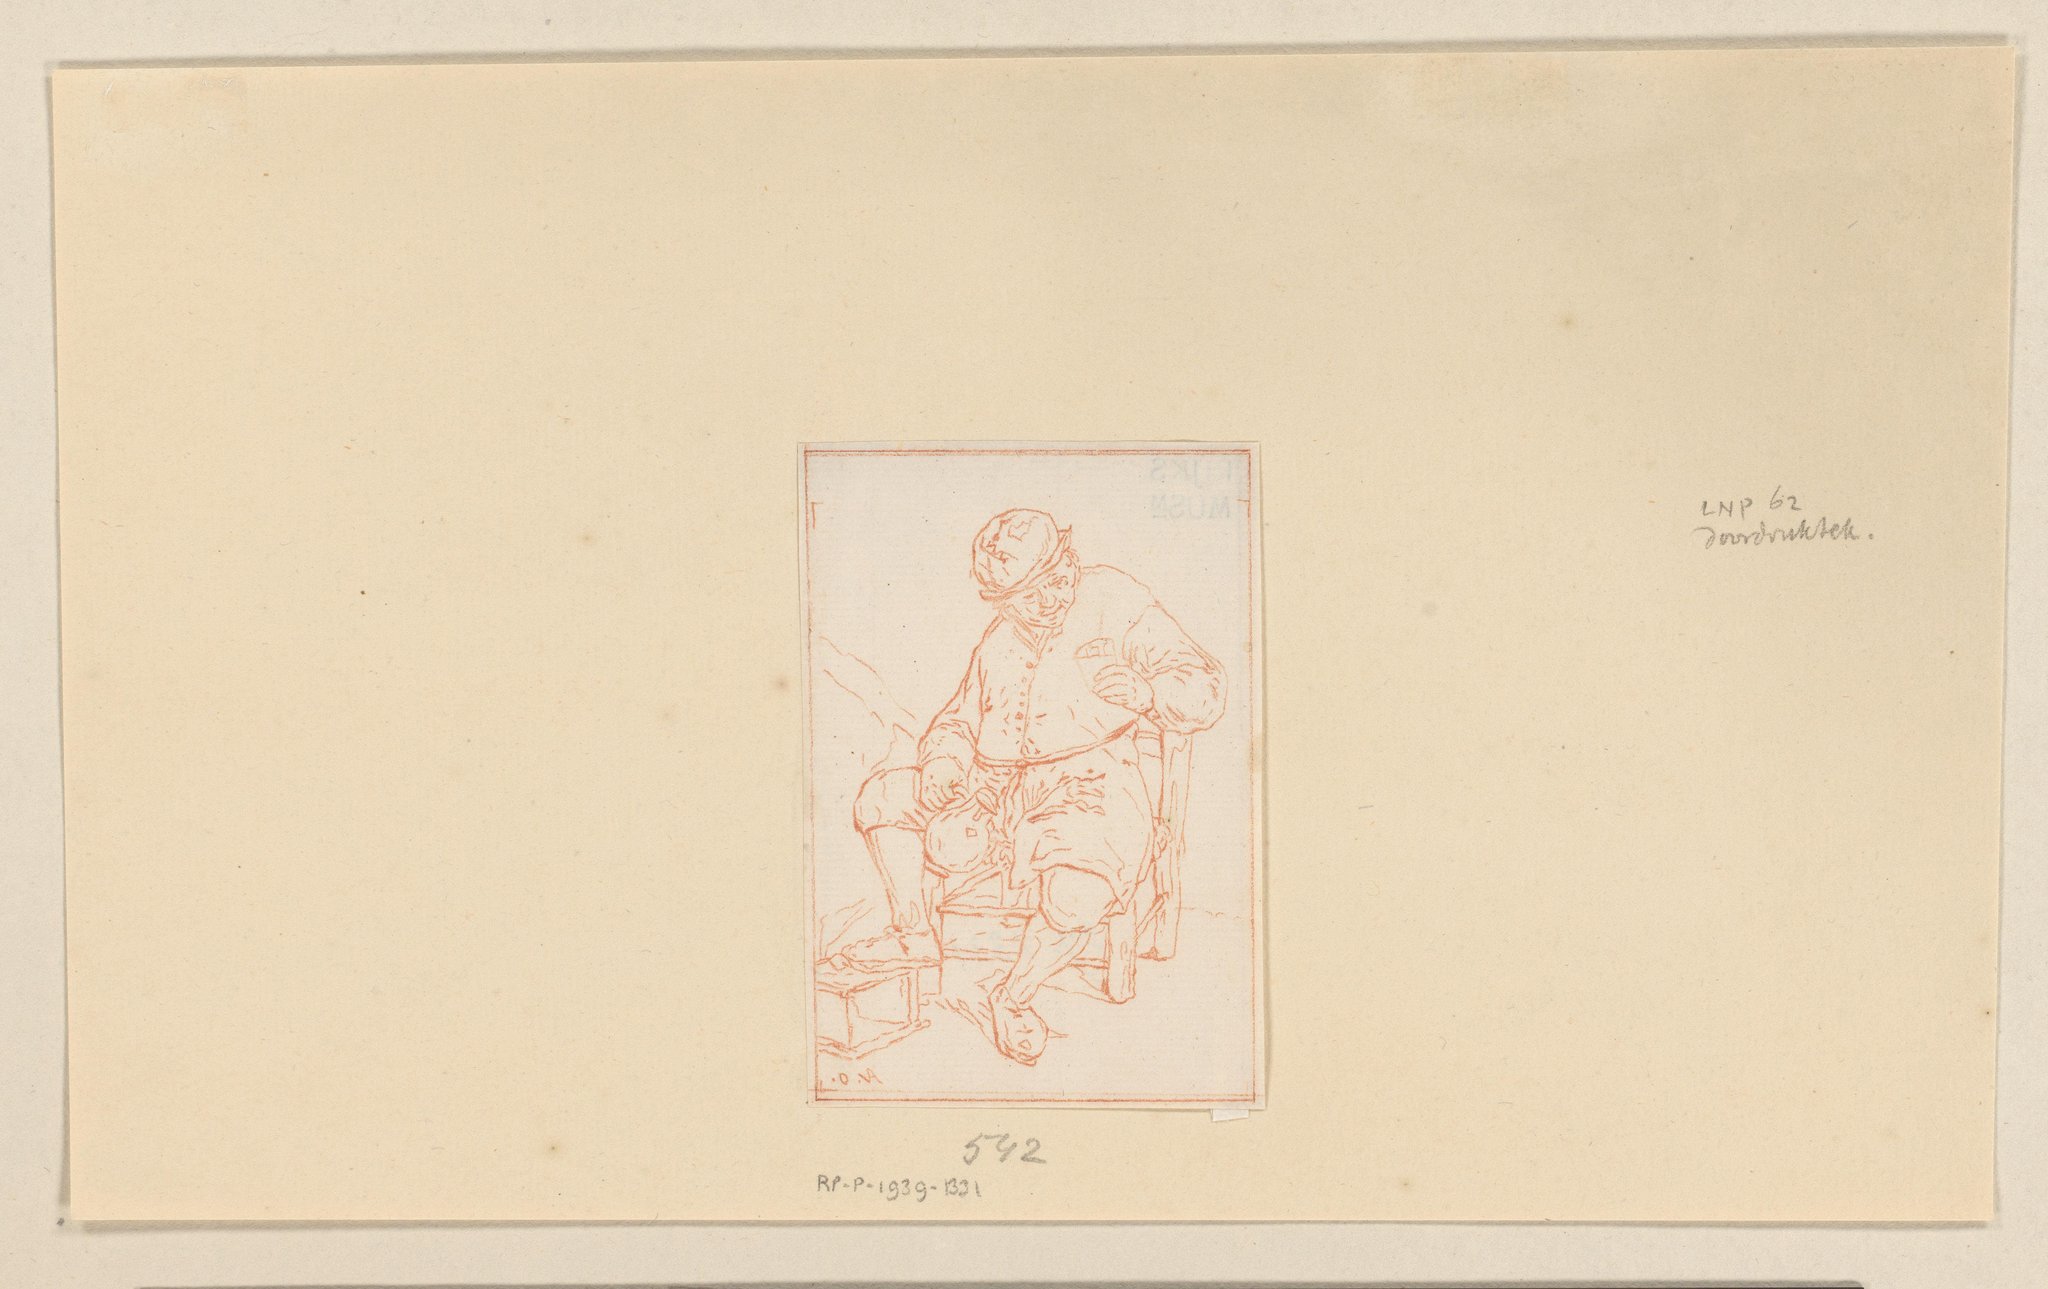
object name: drawing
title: Zittende boer met kruik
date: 1739-1798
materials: chalk, paper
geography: amsterdam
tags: sitting figure, jar, jug (used as drinking-vessel)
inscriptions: collector's mark: ‘RIJKS / MUSM’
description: Een boer zit op een stoel met een glas in de ene en een kruik in de andere hand. De doordruktekening ligt los in een album, zie blad 62.